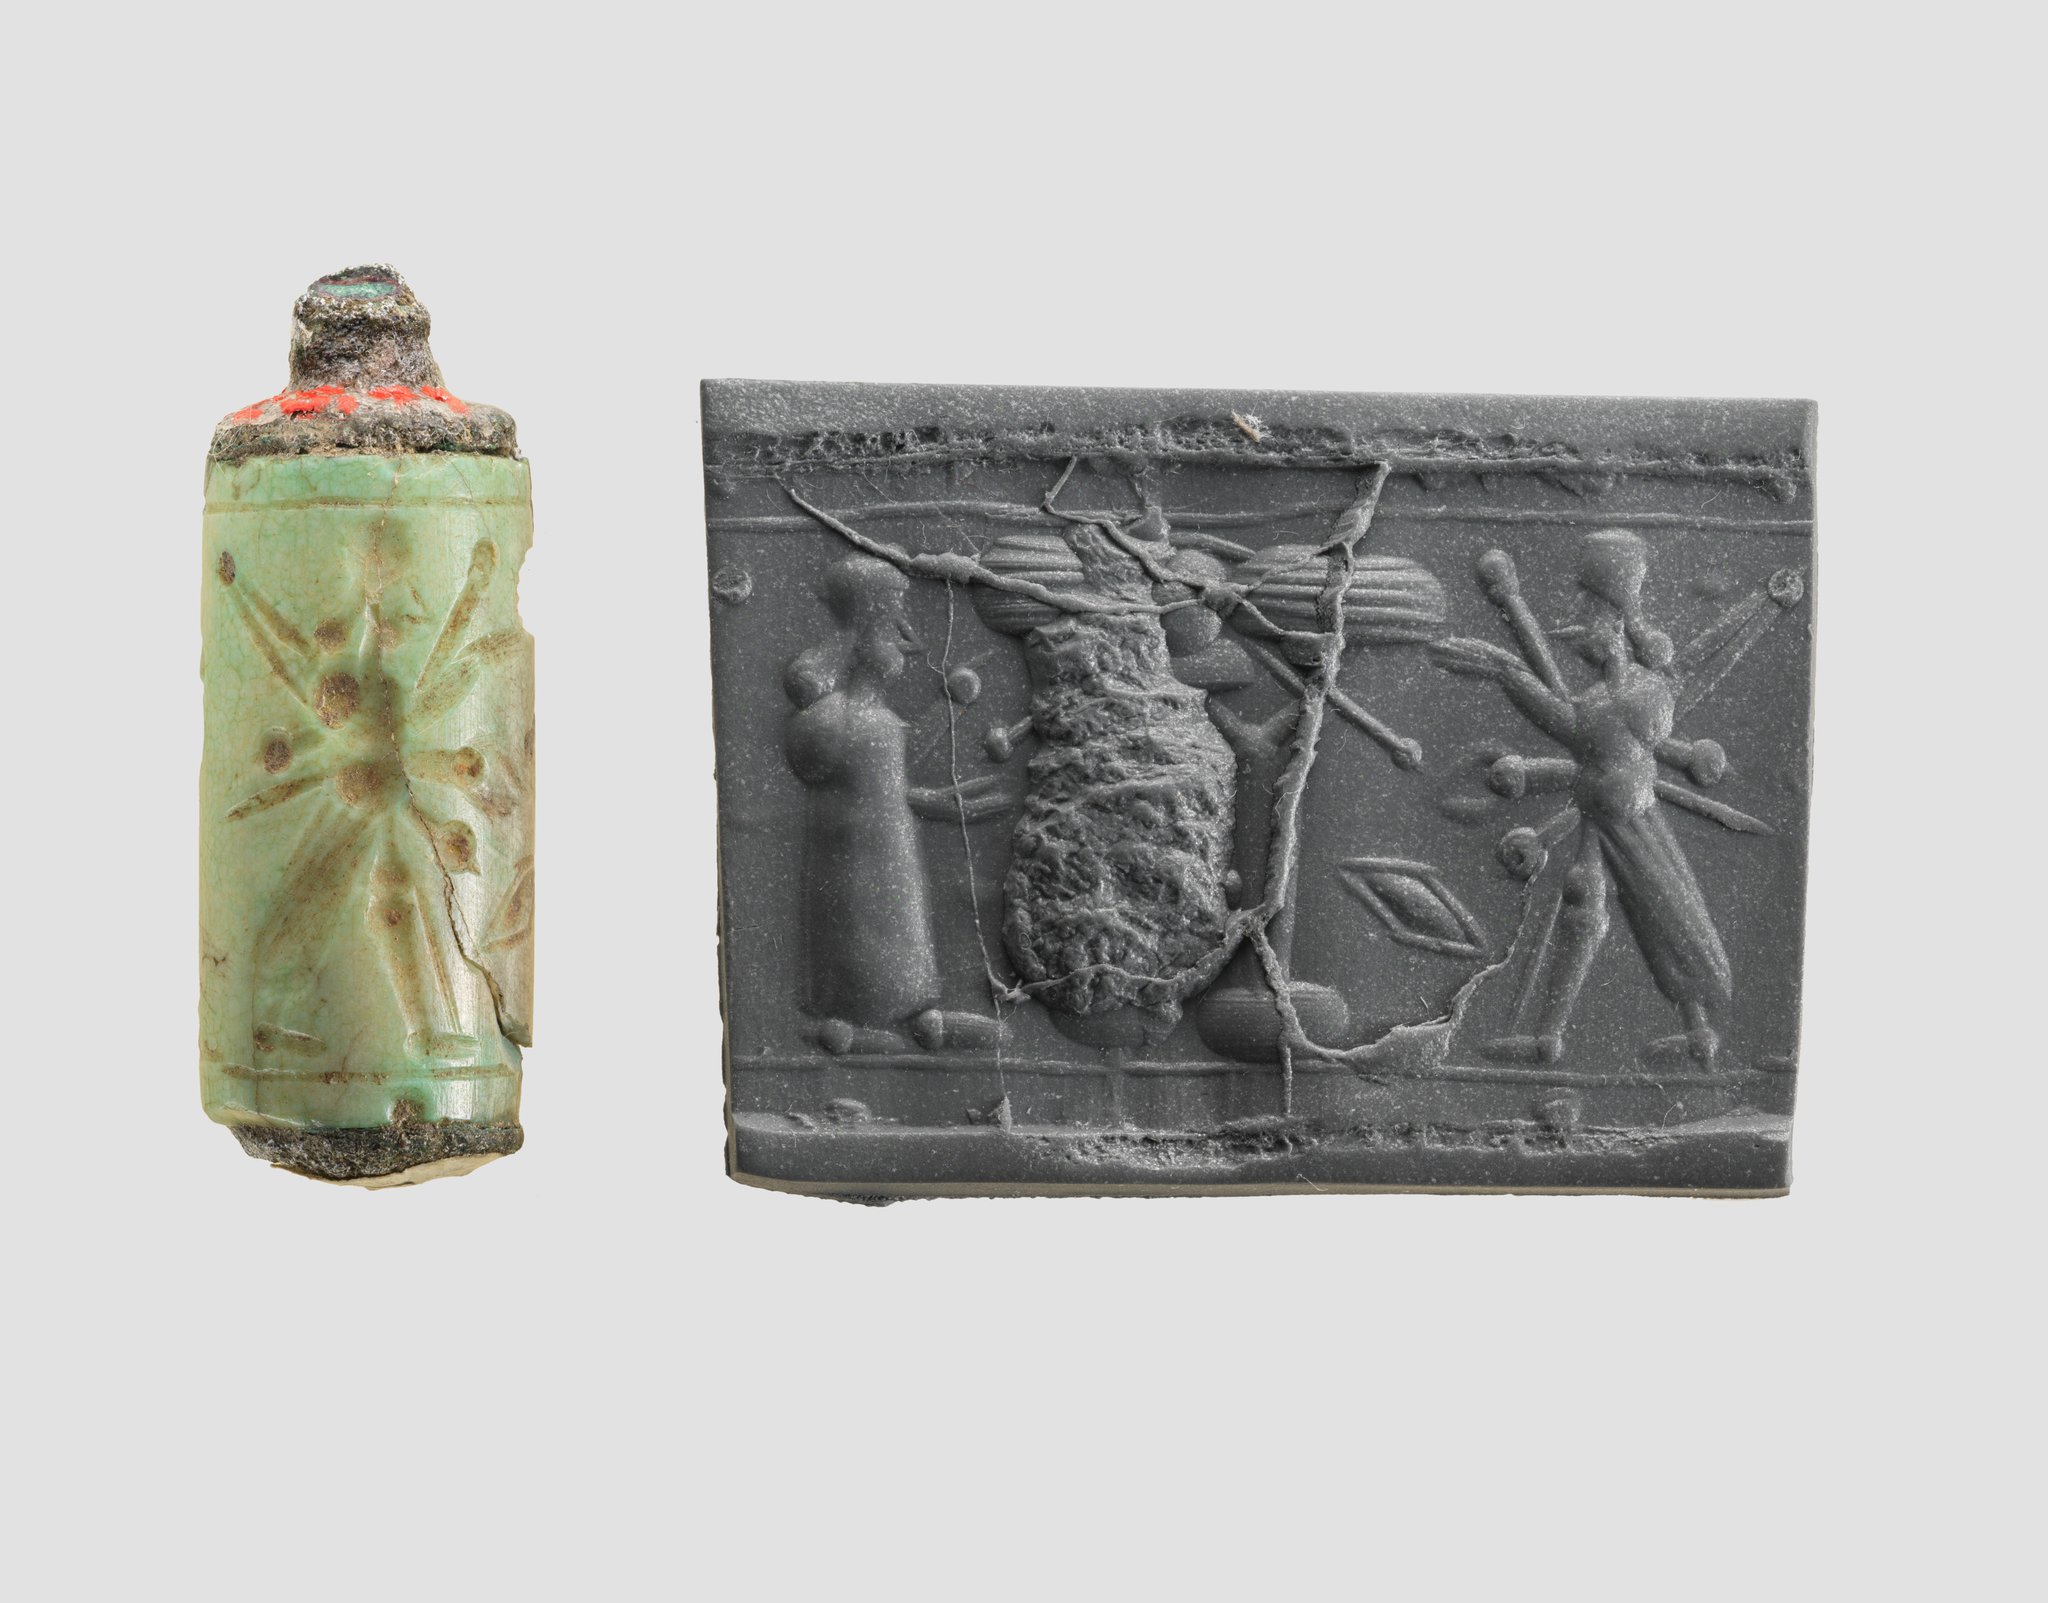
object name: cylinder seal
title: Cylinder seal (with caps preserved) with cultic scene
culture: assyrian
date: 734-601 BCE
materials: bronze, stone, copper, dye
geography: mesopotamia